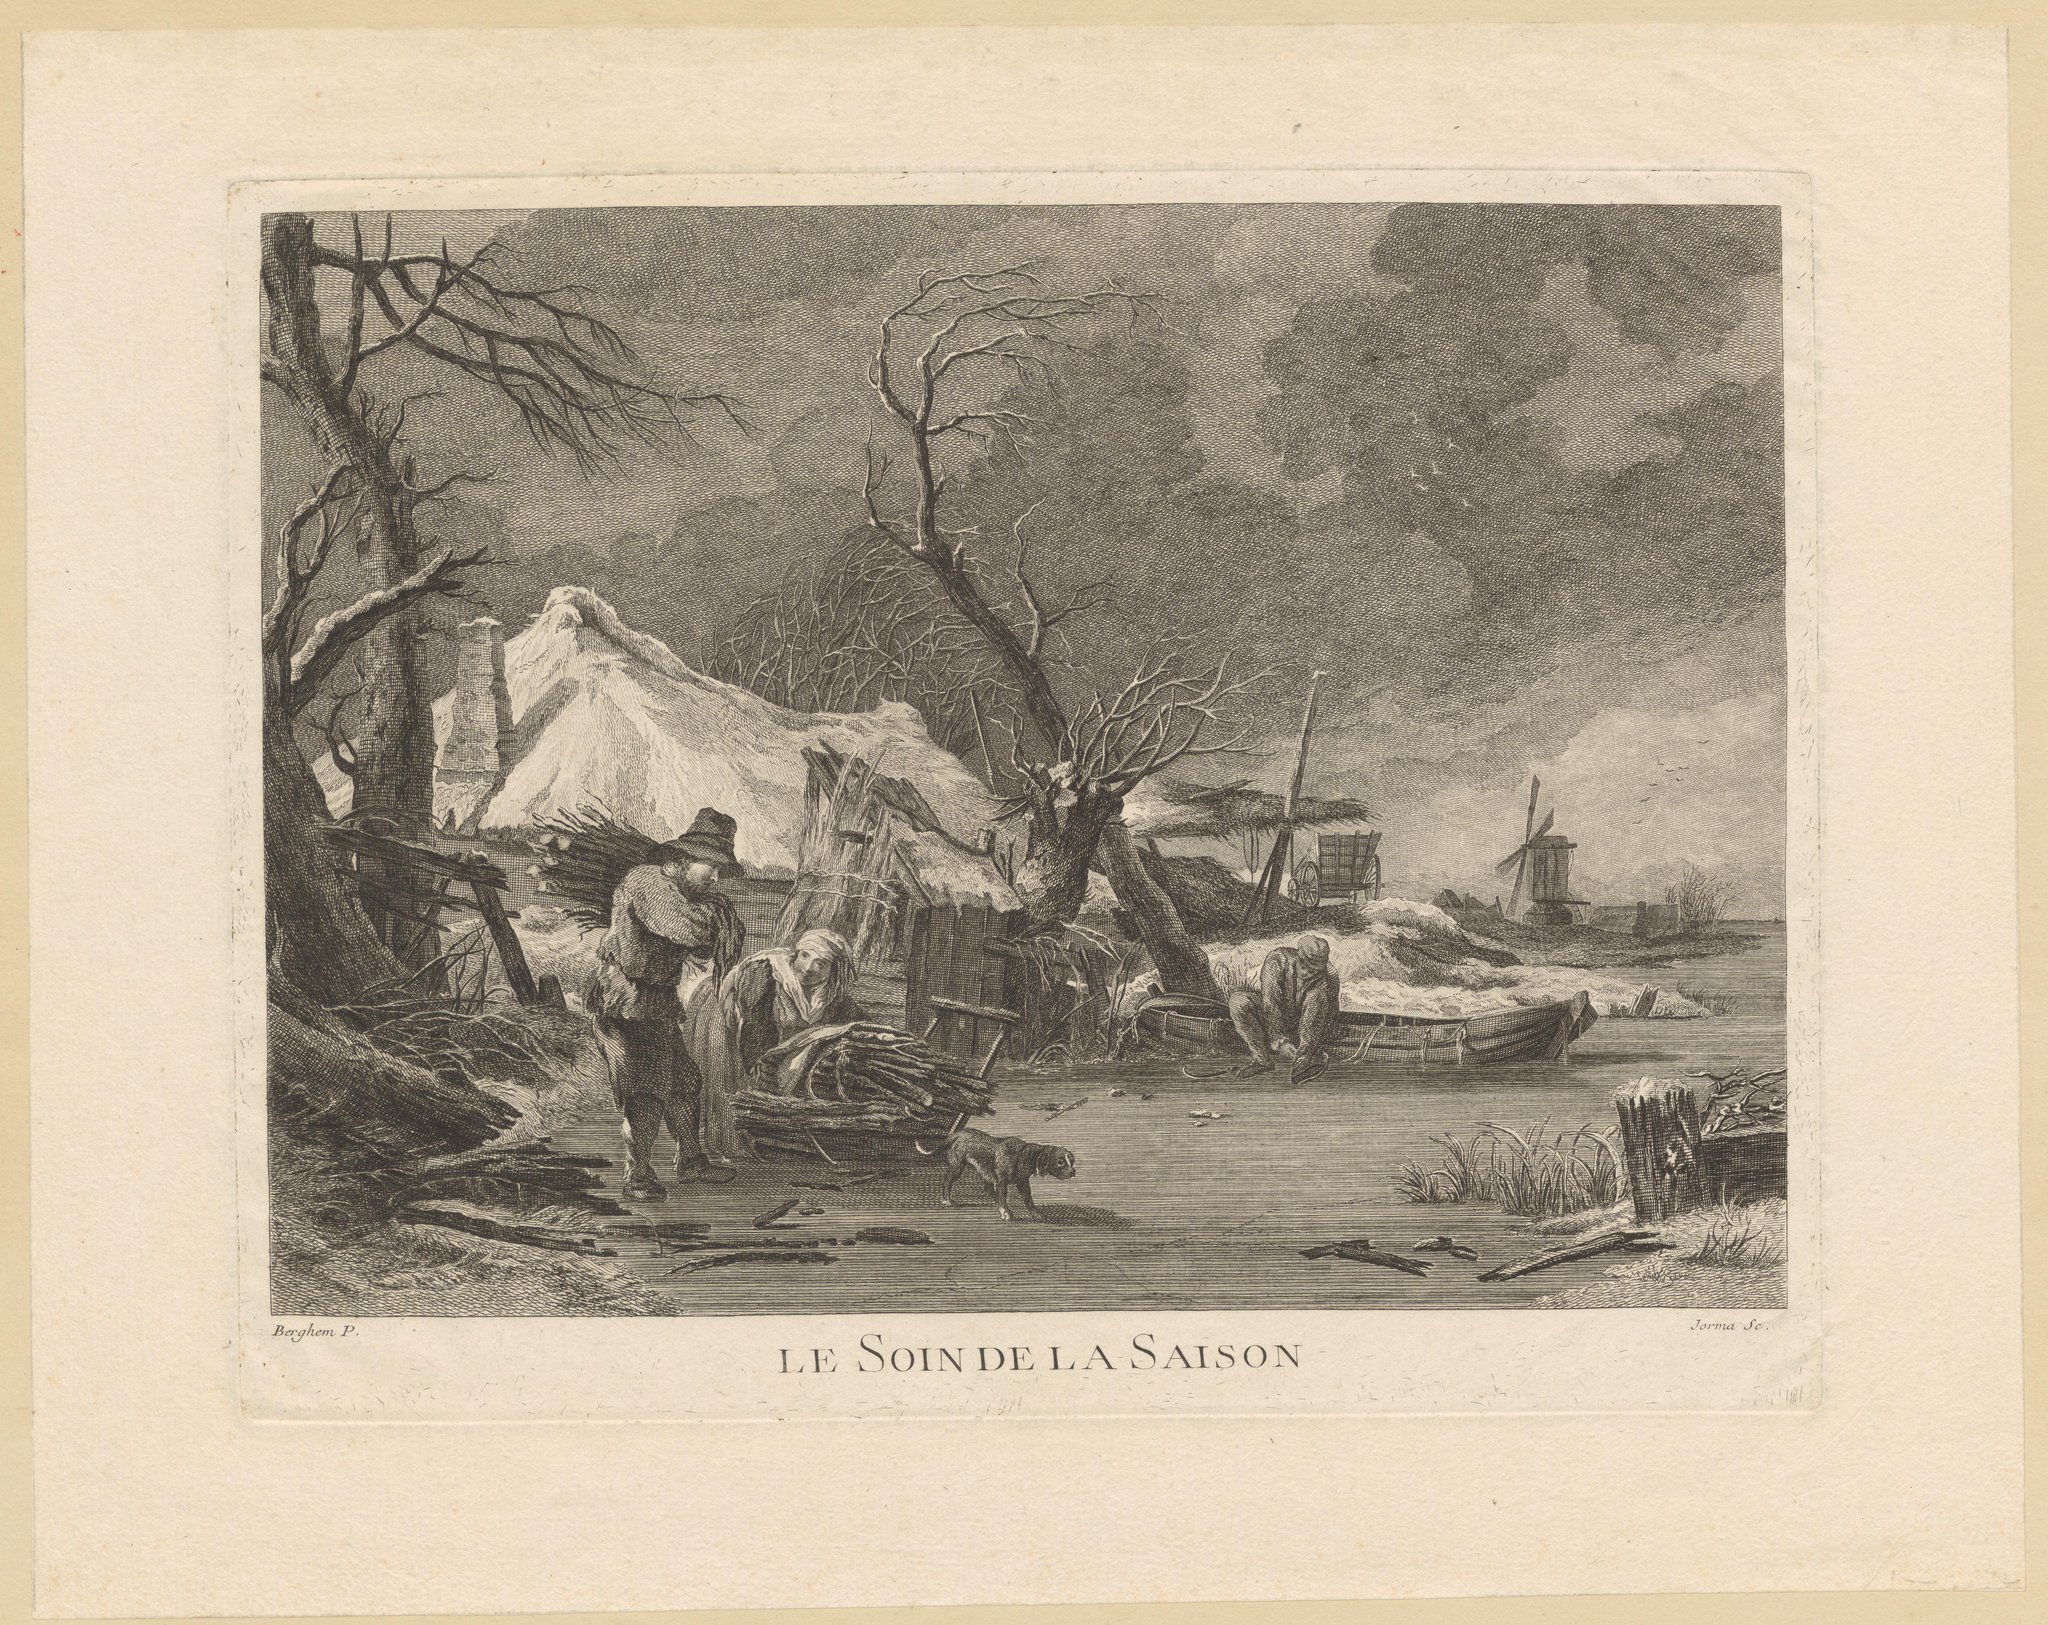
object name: print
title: Winterlandschap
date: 1724-1799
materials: paper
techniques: etching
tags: winter ~ human activities (the four seasons of the year), netherlands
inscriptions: collector's mark: Lugt 240